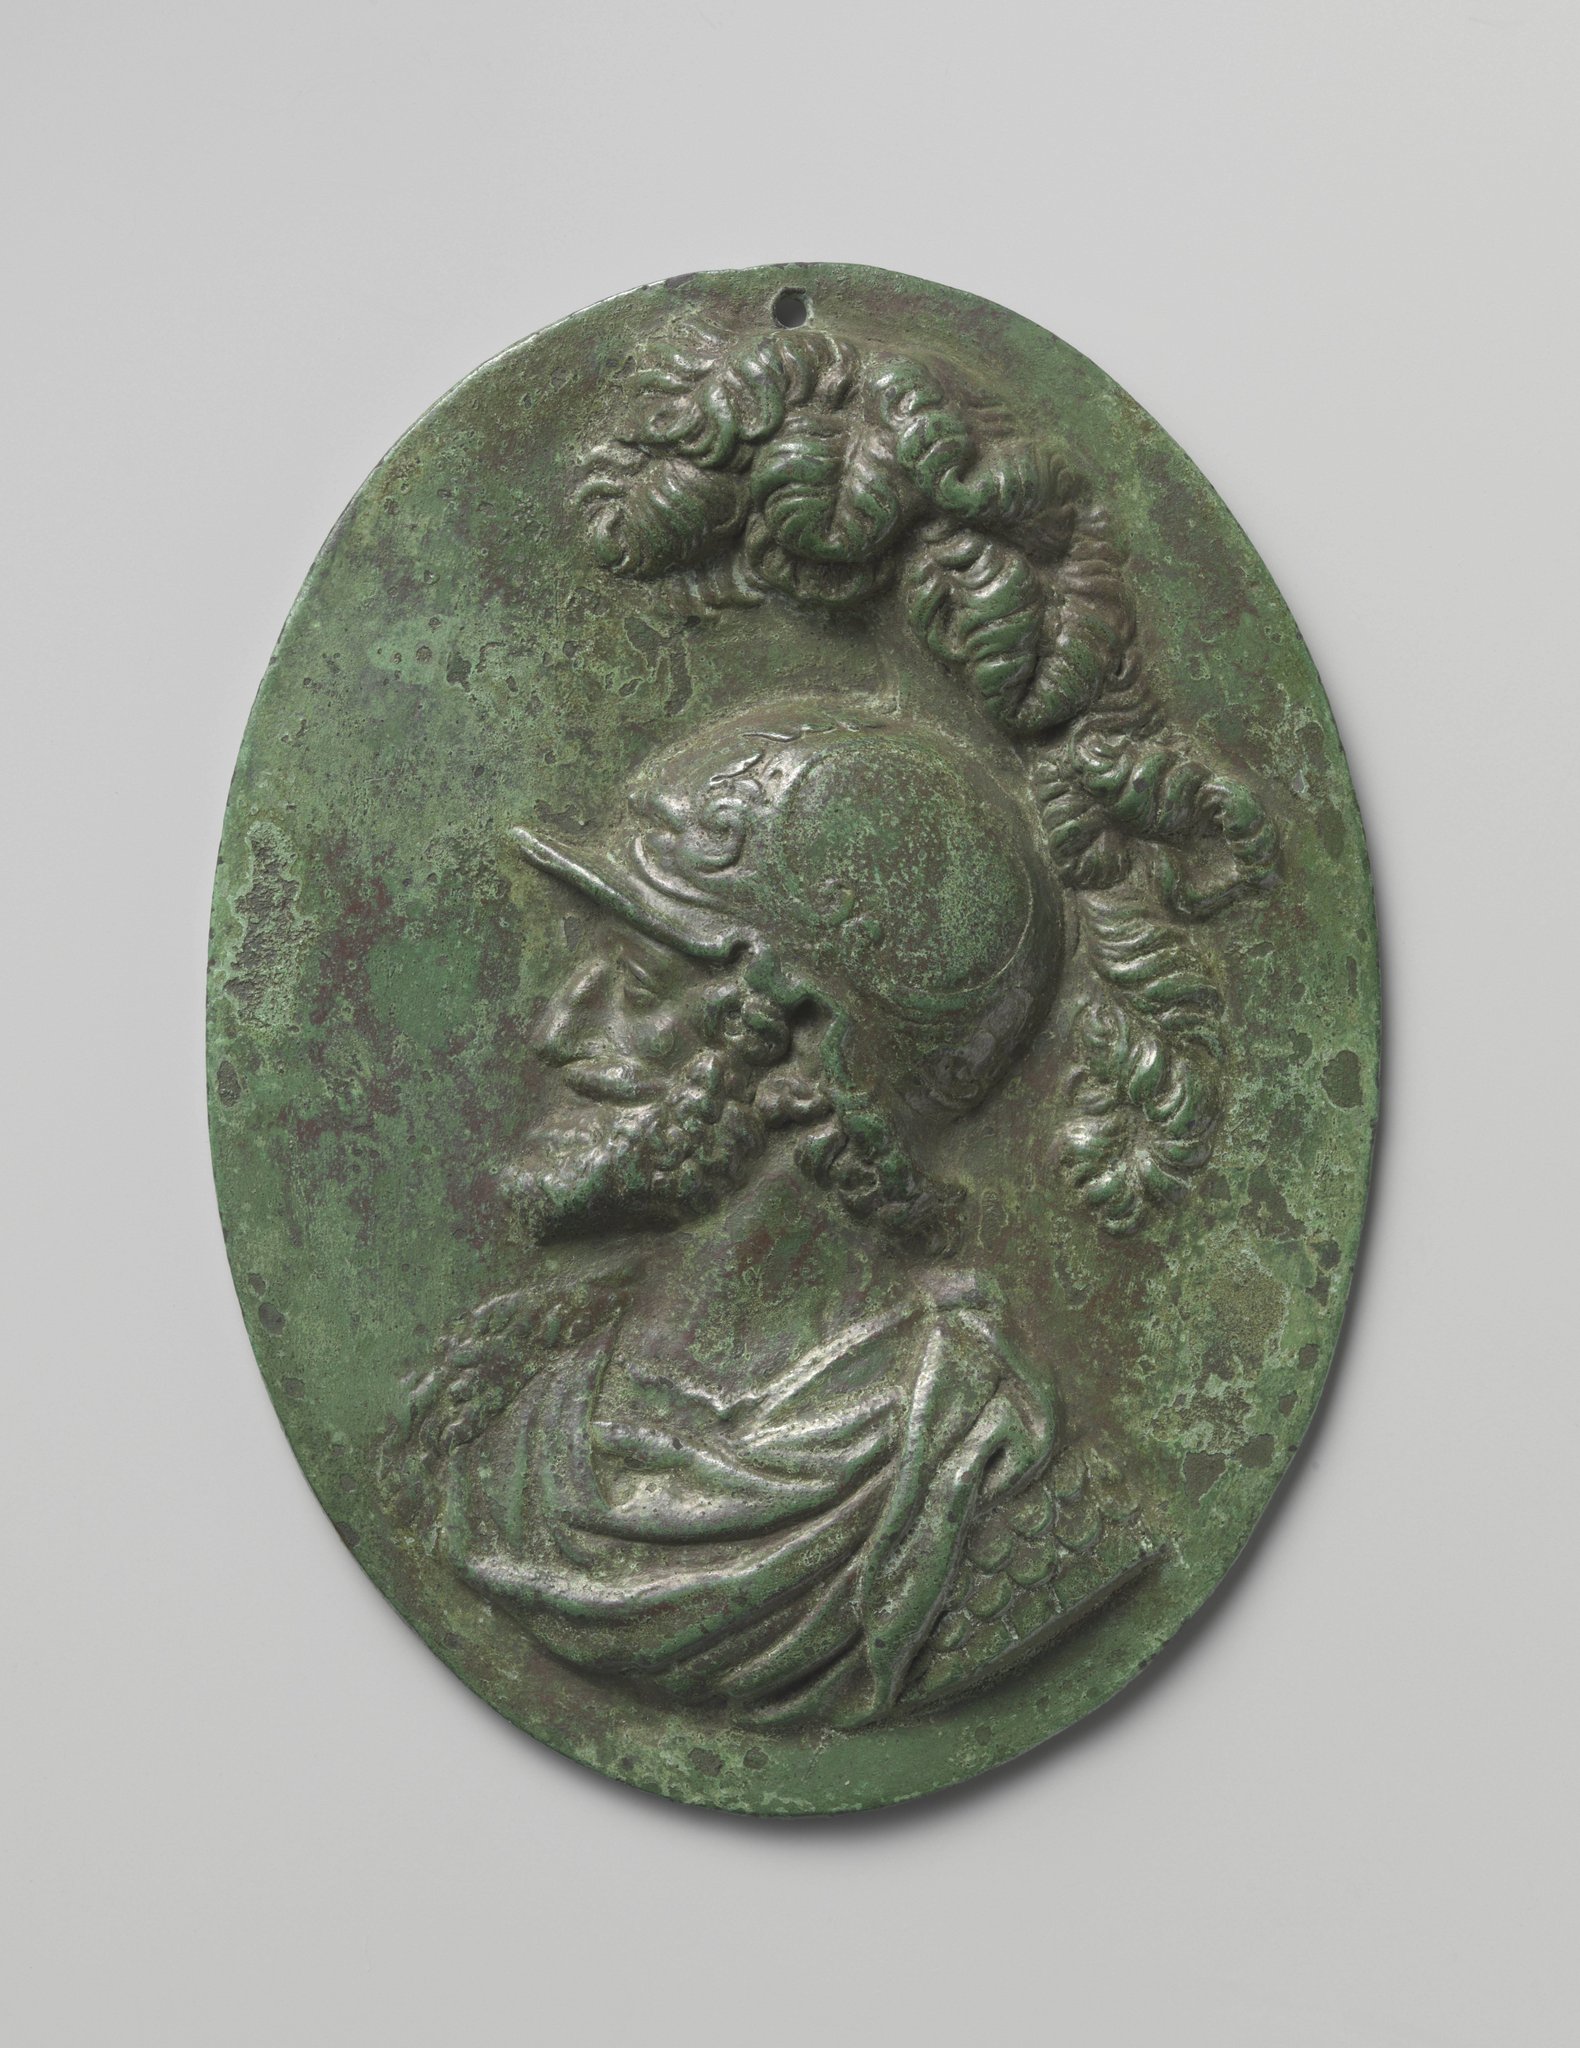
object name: sculpture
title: Medaillonportret van Hendrik IV van Frankrijk (1553-1610)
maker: Anonymous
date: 1700-1800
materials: bronze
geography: france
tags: paris, hendrik iv (koning van frankrijk en navarra), historical persons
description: Hendrik IV van Frankrijk, in profiel naar links, gekleed in Romeins kostuum met gevederde helm.